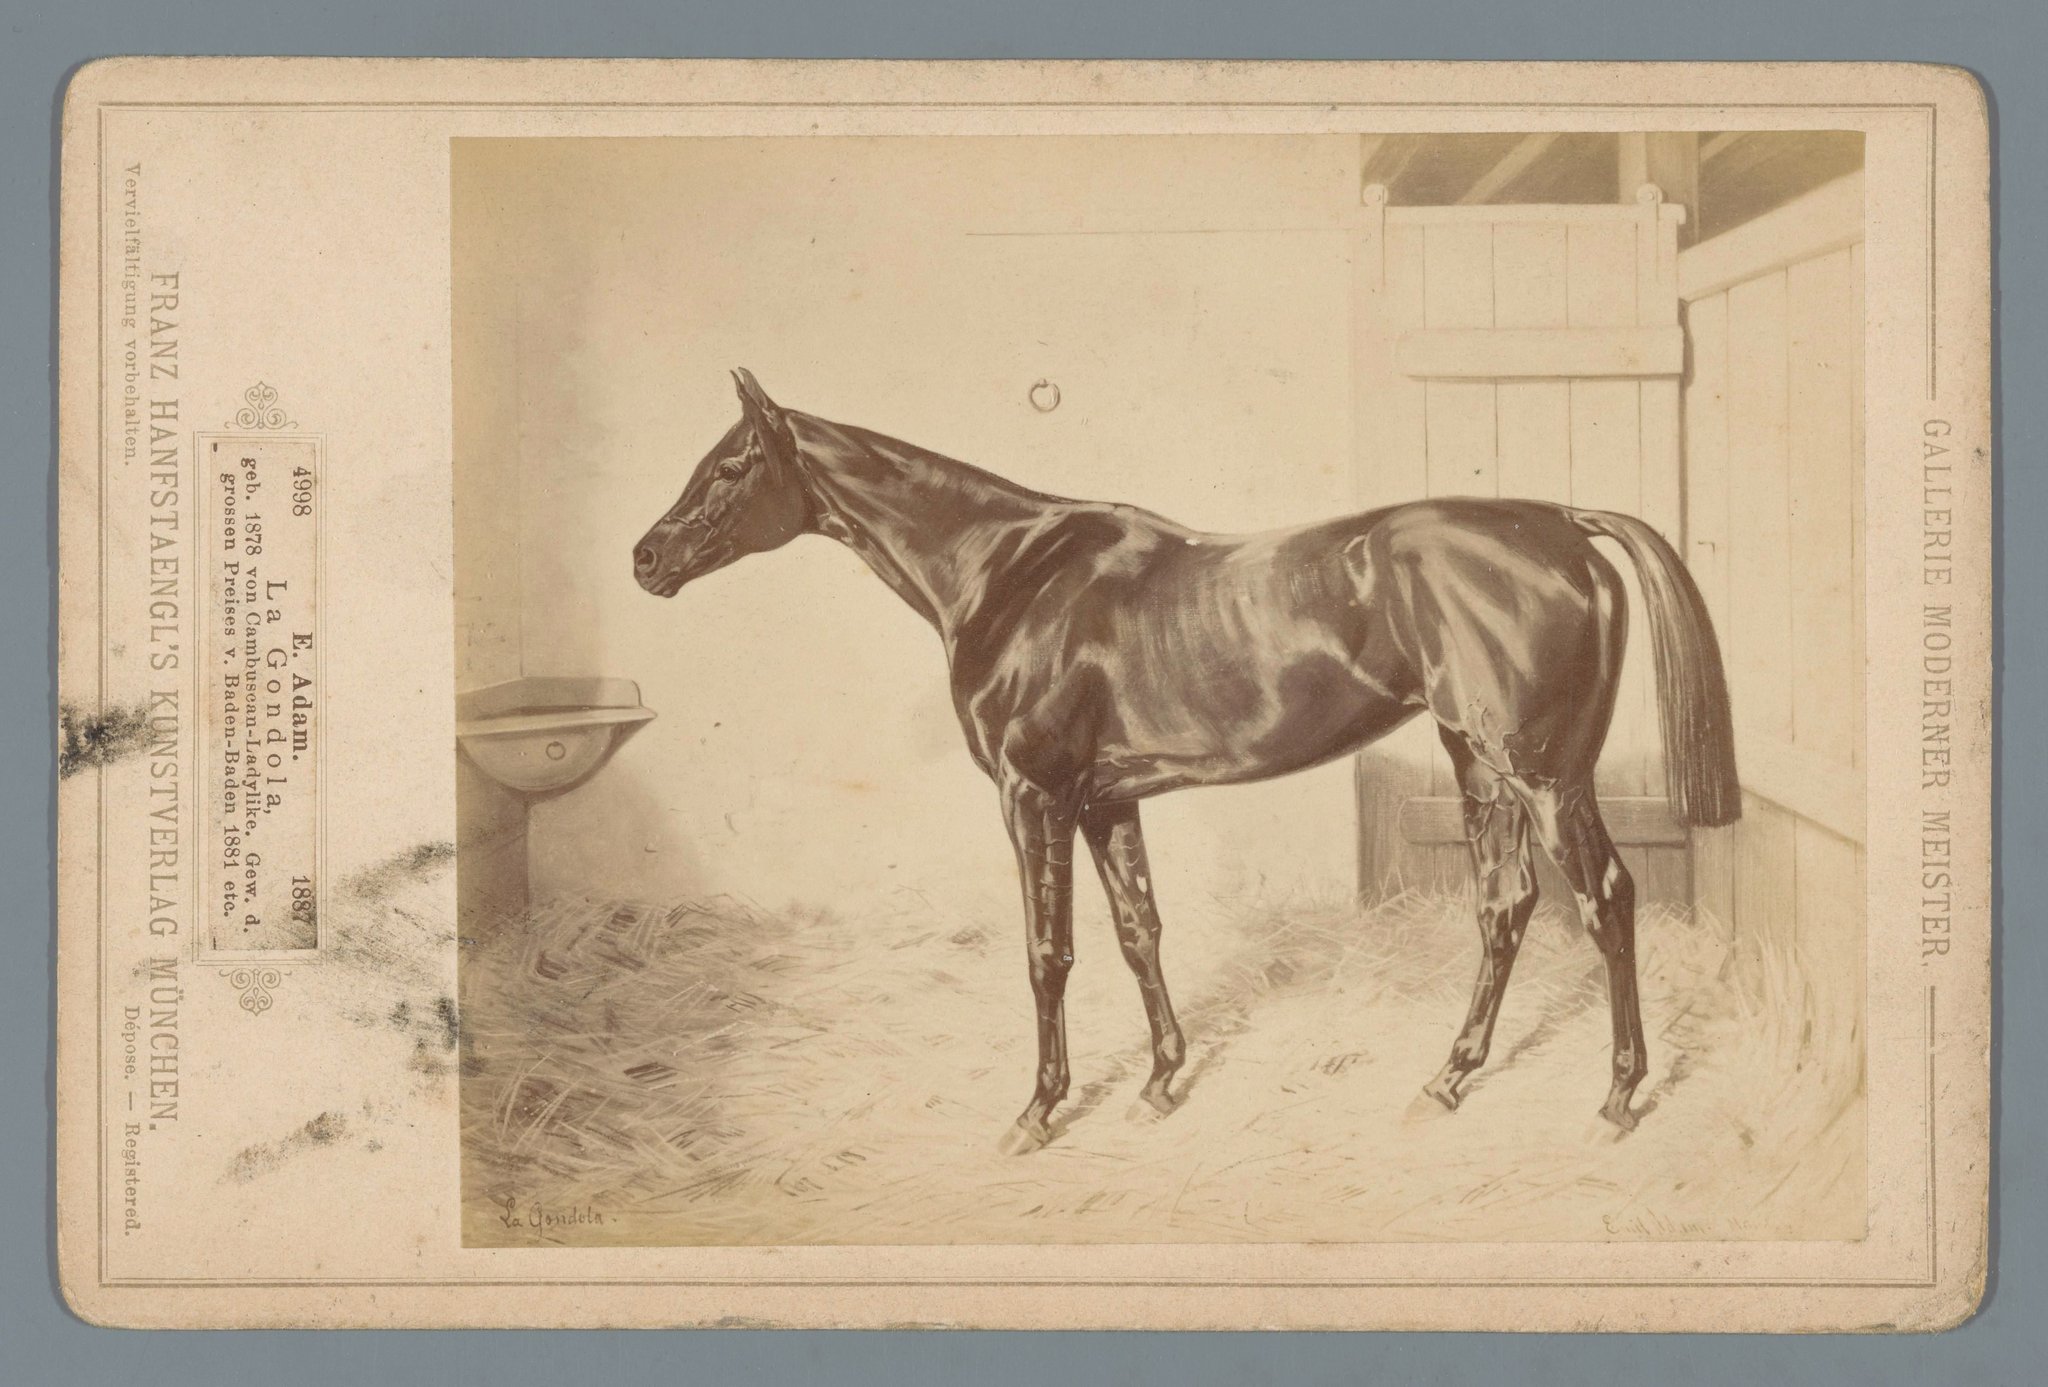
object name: reproduction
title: Fotoreproductie van een schilderij van het paard La Gondola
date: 1887-1910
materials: cardboard, photographic support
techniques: albumen print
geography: germany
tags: horse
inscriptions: number: ‘4998’, inscription: ‘geb. 1878 von Cambuscan-Ladylike. Gew. d. grossen Preises v. Baden-Baden 1881 etc.’